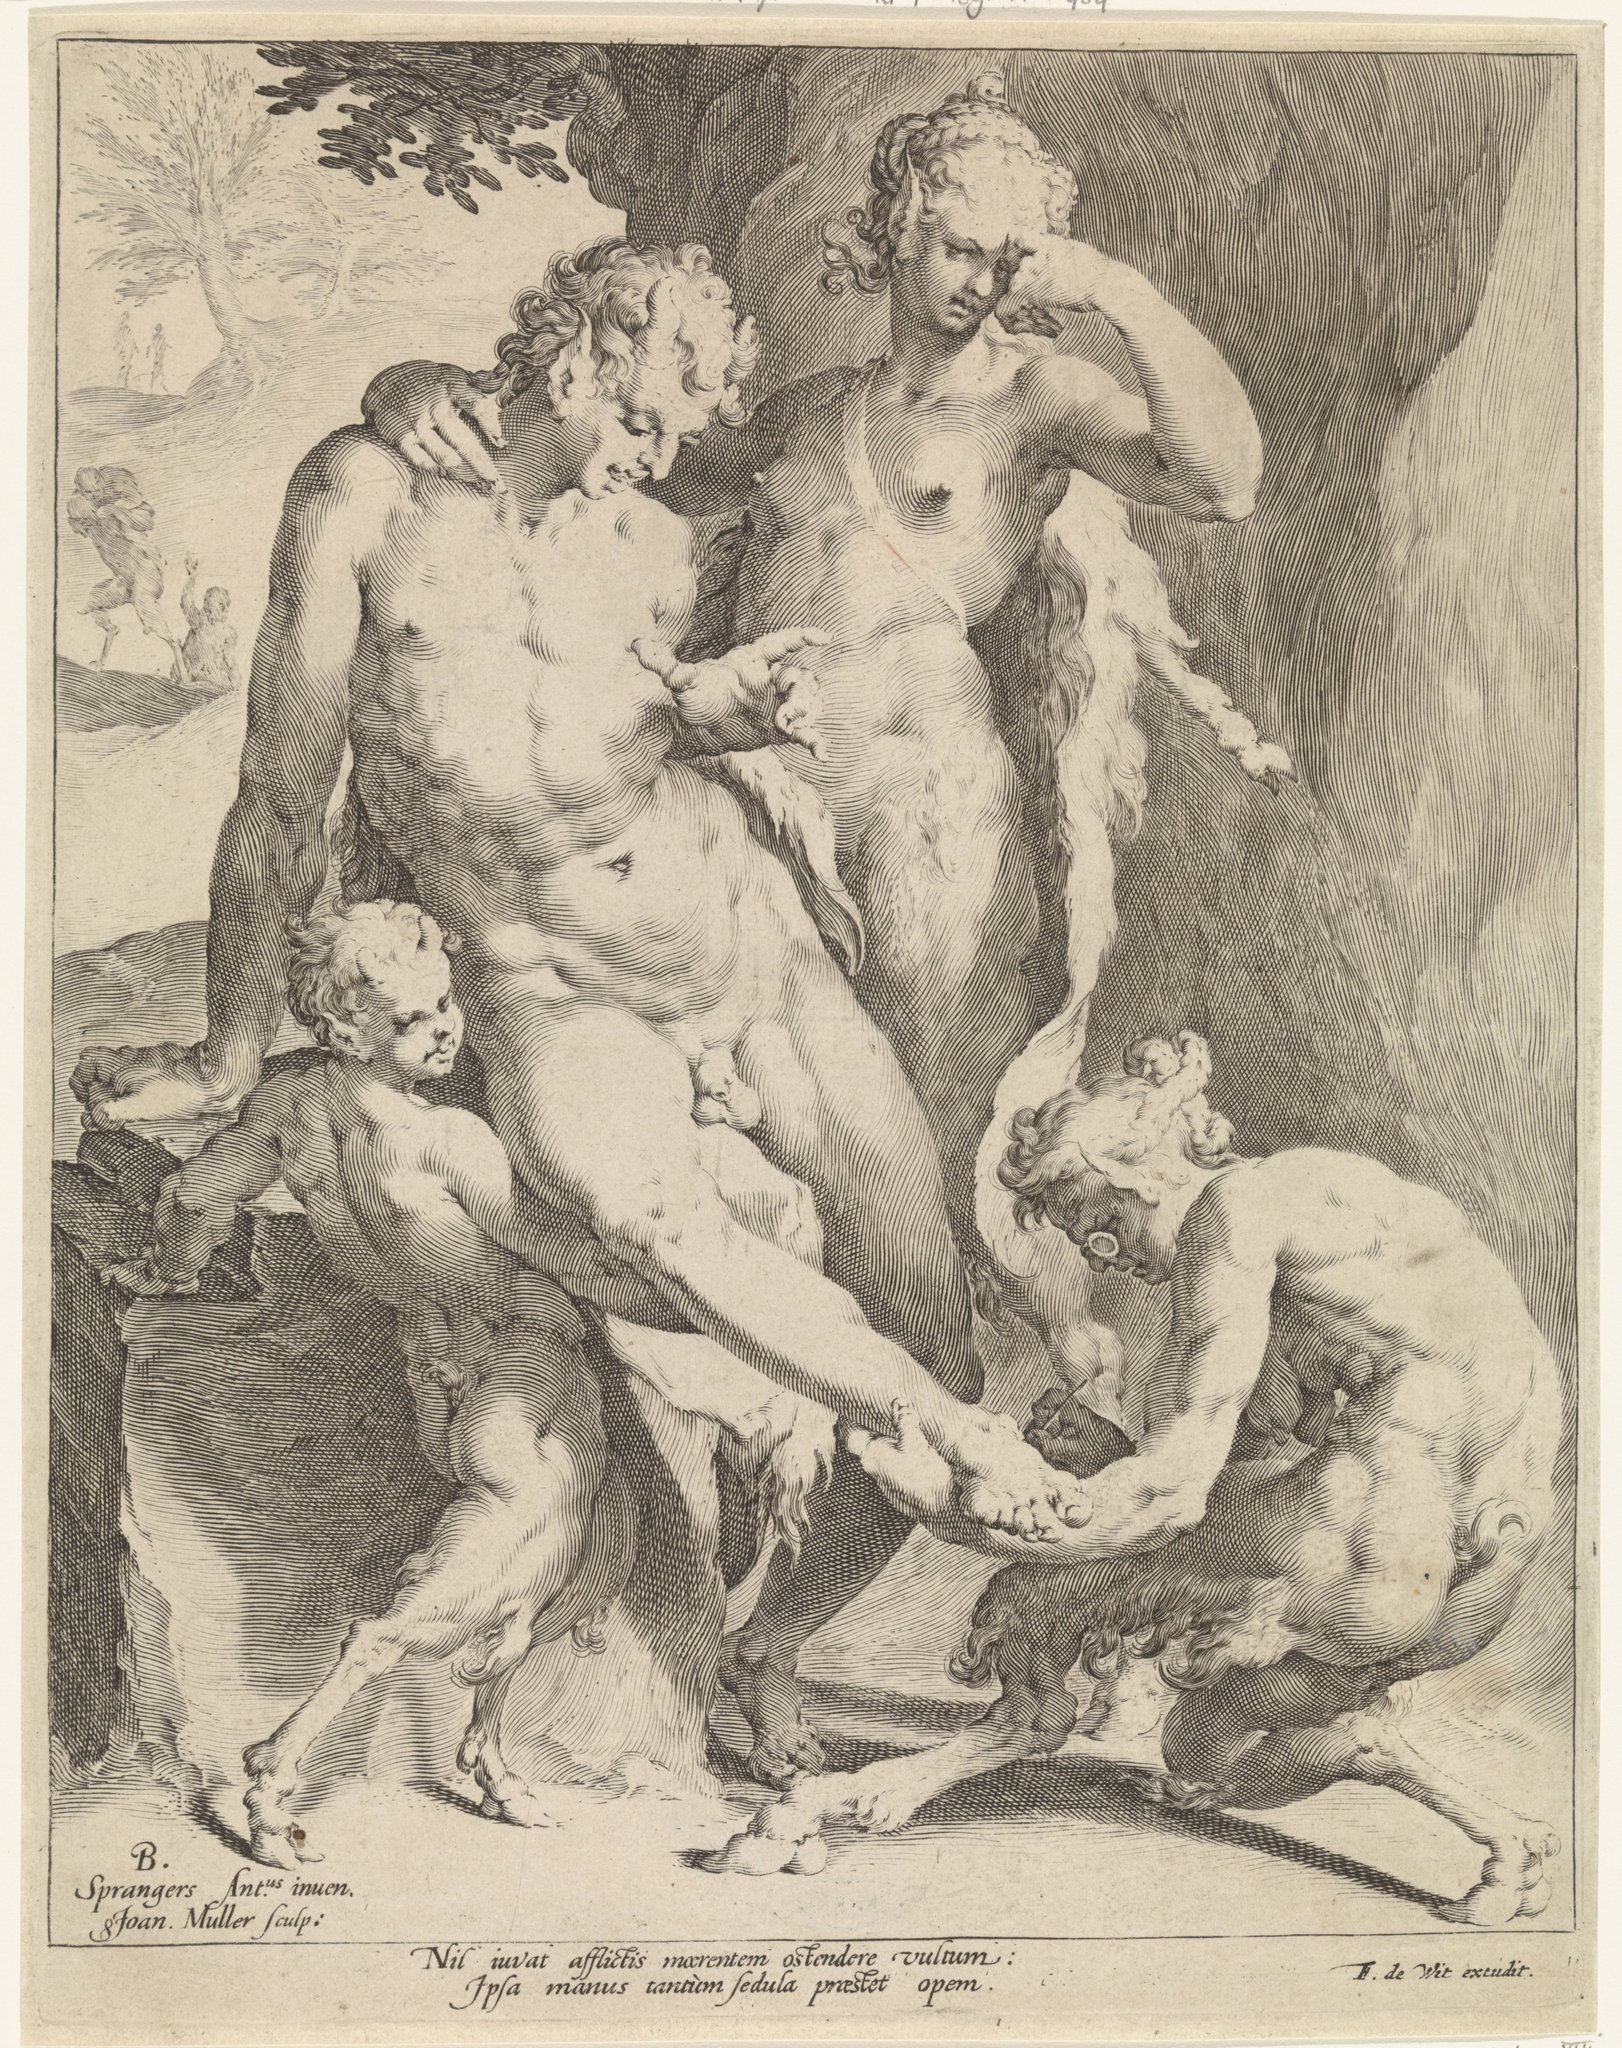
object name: print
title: Oreaden verwijderen een doorn uit de voet van een sater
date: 1640-1706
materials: paper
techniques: engraving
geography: amsterdam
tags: 'spinario', child pulling a thorn out of its foot (+ variant), oreads, nymphs of the hills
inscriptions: collector's mark: Lugt 2228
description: Een oreade, met een bril op de neus, verwijdert een doorn uit de voet van een sater. De sater wordt ondersteund door een vrouwelijke en een jonge oreade. Onderaan in de marge een tweeregelige tekst in het Latijn.